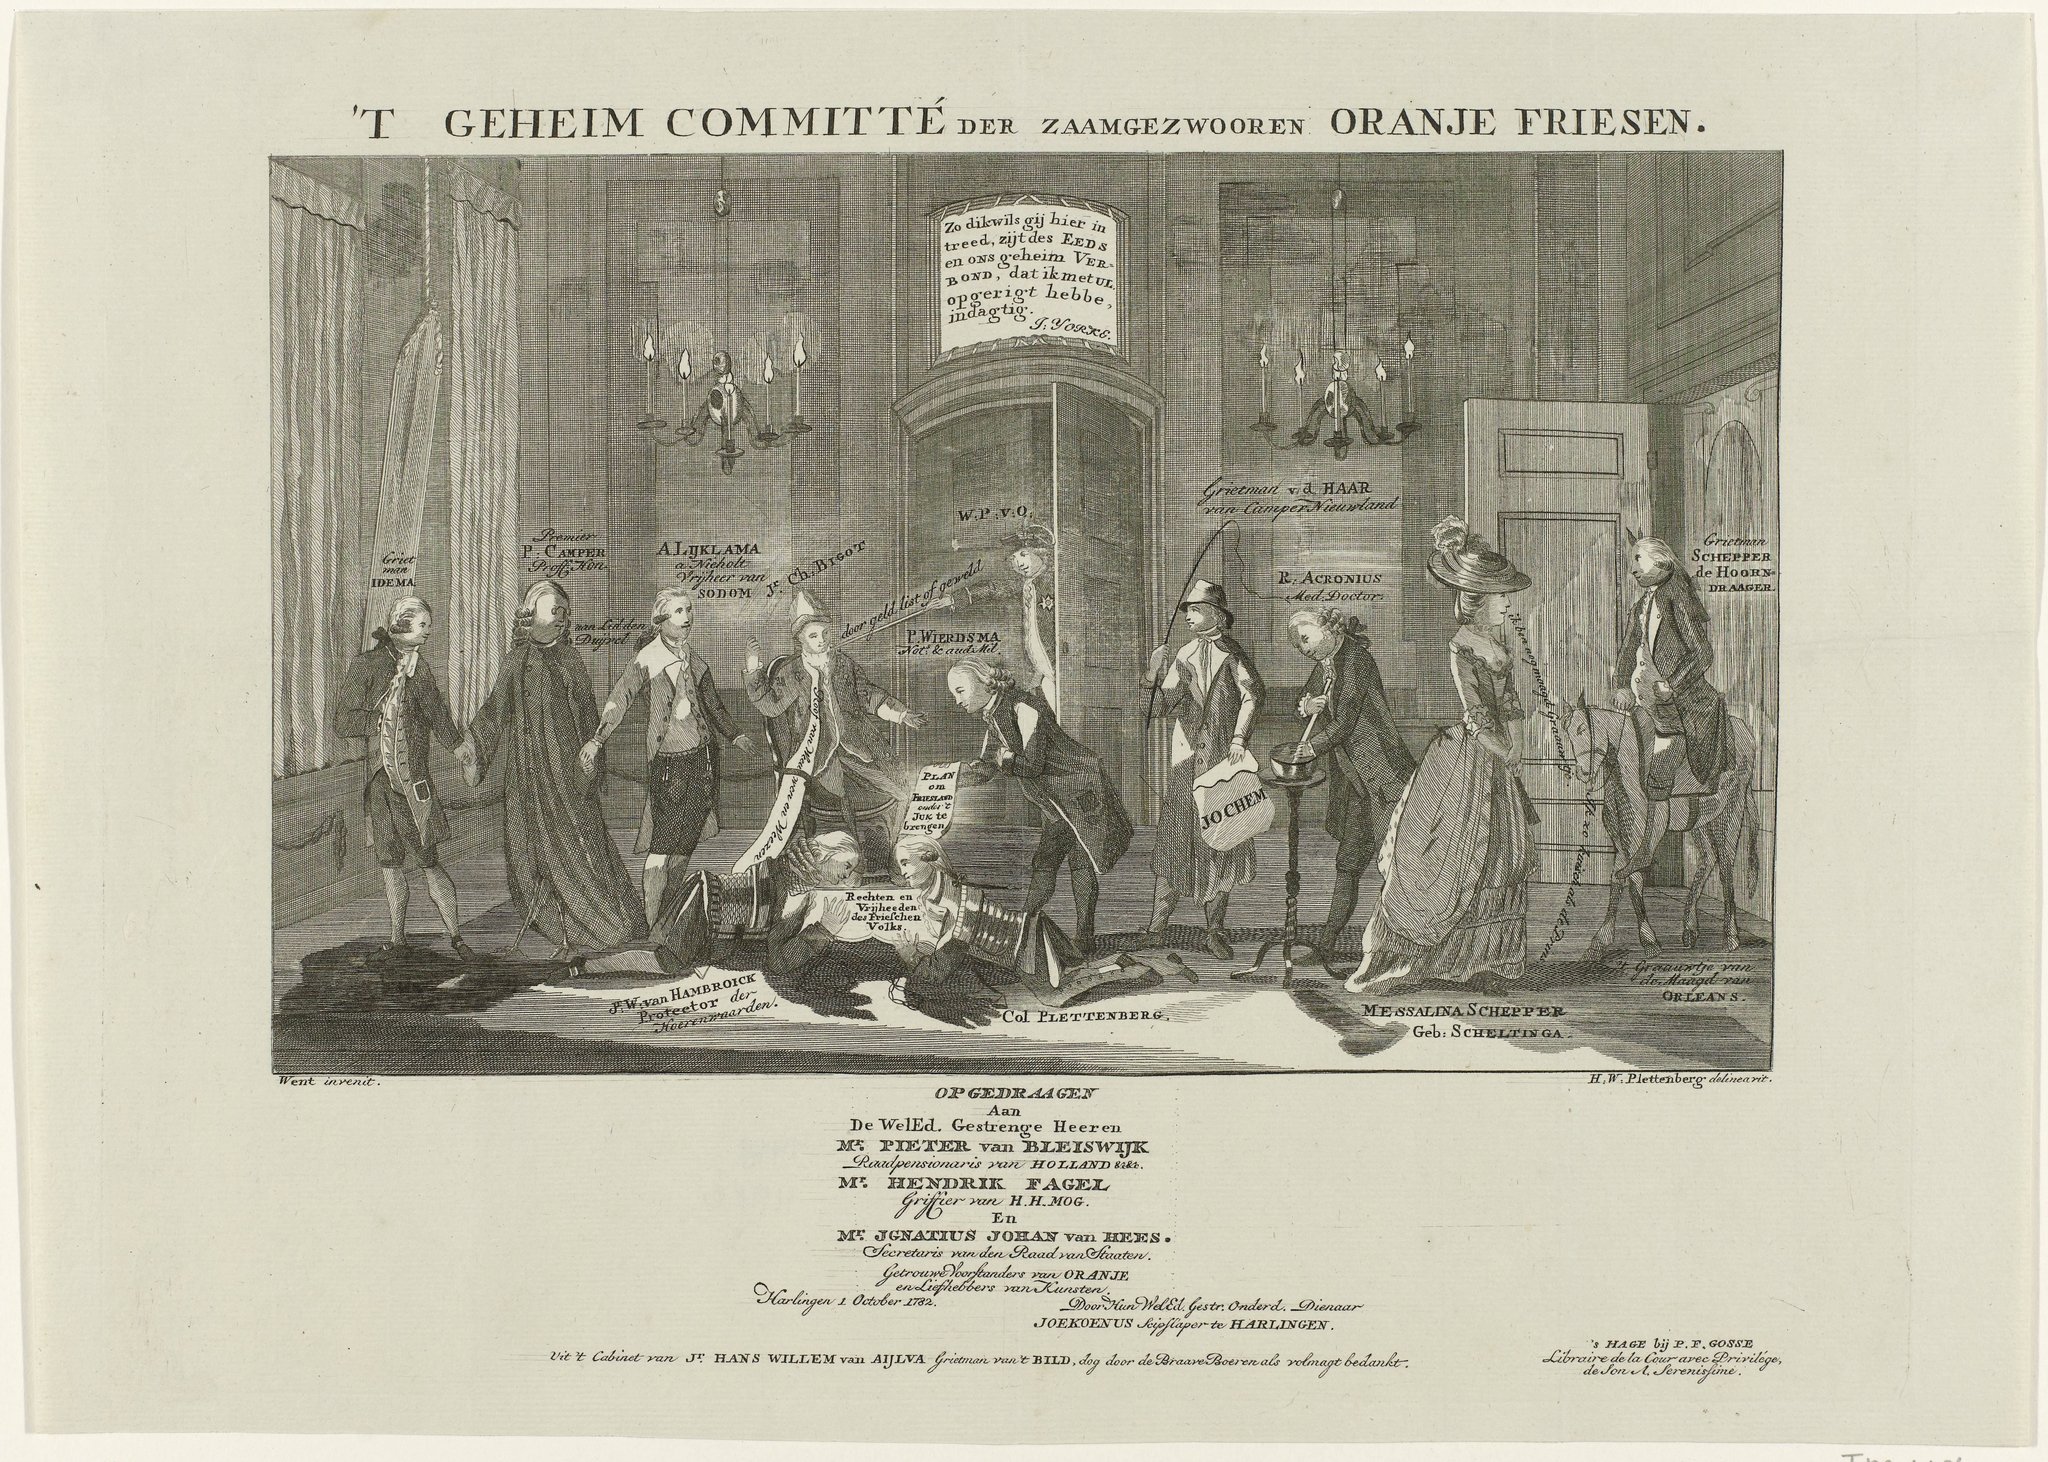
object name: print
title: Spotprent op de prins en zijn aanhang, 1782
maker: Anonymous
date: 1782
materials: paper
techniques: etching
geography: northern netherlands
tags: william v (prince of orange), the hague, print maker, draughtsman, petrus camper, political caricatures and satires, patriots (1780-1795)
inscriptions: collector's mark: Lugt 2228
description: Spotprent op prins Willem V van Oranje en de Friese tak. Kamer waarin de prins binnenkomt, centraal staat P. Wierdsma met 'Plan om Friesland onder 't juk te brengen' en de twee heren Jr. W. van Hambroick Protector der Hoerenwaarden en Col. Plettenberg op de grond met zadels op hun vrouwenrug met 'Rechten en Vrijheeden der Frieschen Volks'. Links grietman Idema, professor Petrus Camper, A. Lyklama a Nieholt Vrijheer van Sodom, Jr. Ch. Bigot. Rechts Grietman v.d. Haar, R. Acronius, Messalina Schepper Geb: Scheltinga en Grietman Schepper de Hoorndrager rijdend op een ezel. Onder de voorstelling gefingeerde opdracht van 1 oktober 1782 en gefingeerde namen van vervaardigers. De voorstelling van de prent wordt uitgelegd in een "beknopte Verklaaring" en in een pamflet getiteld "De Friesche Volk-stem".